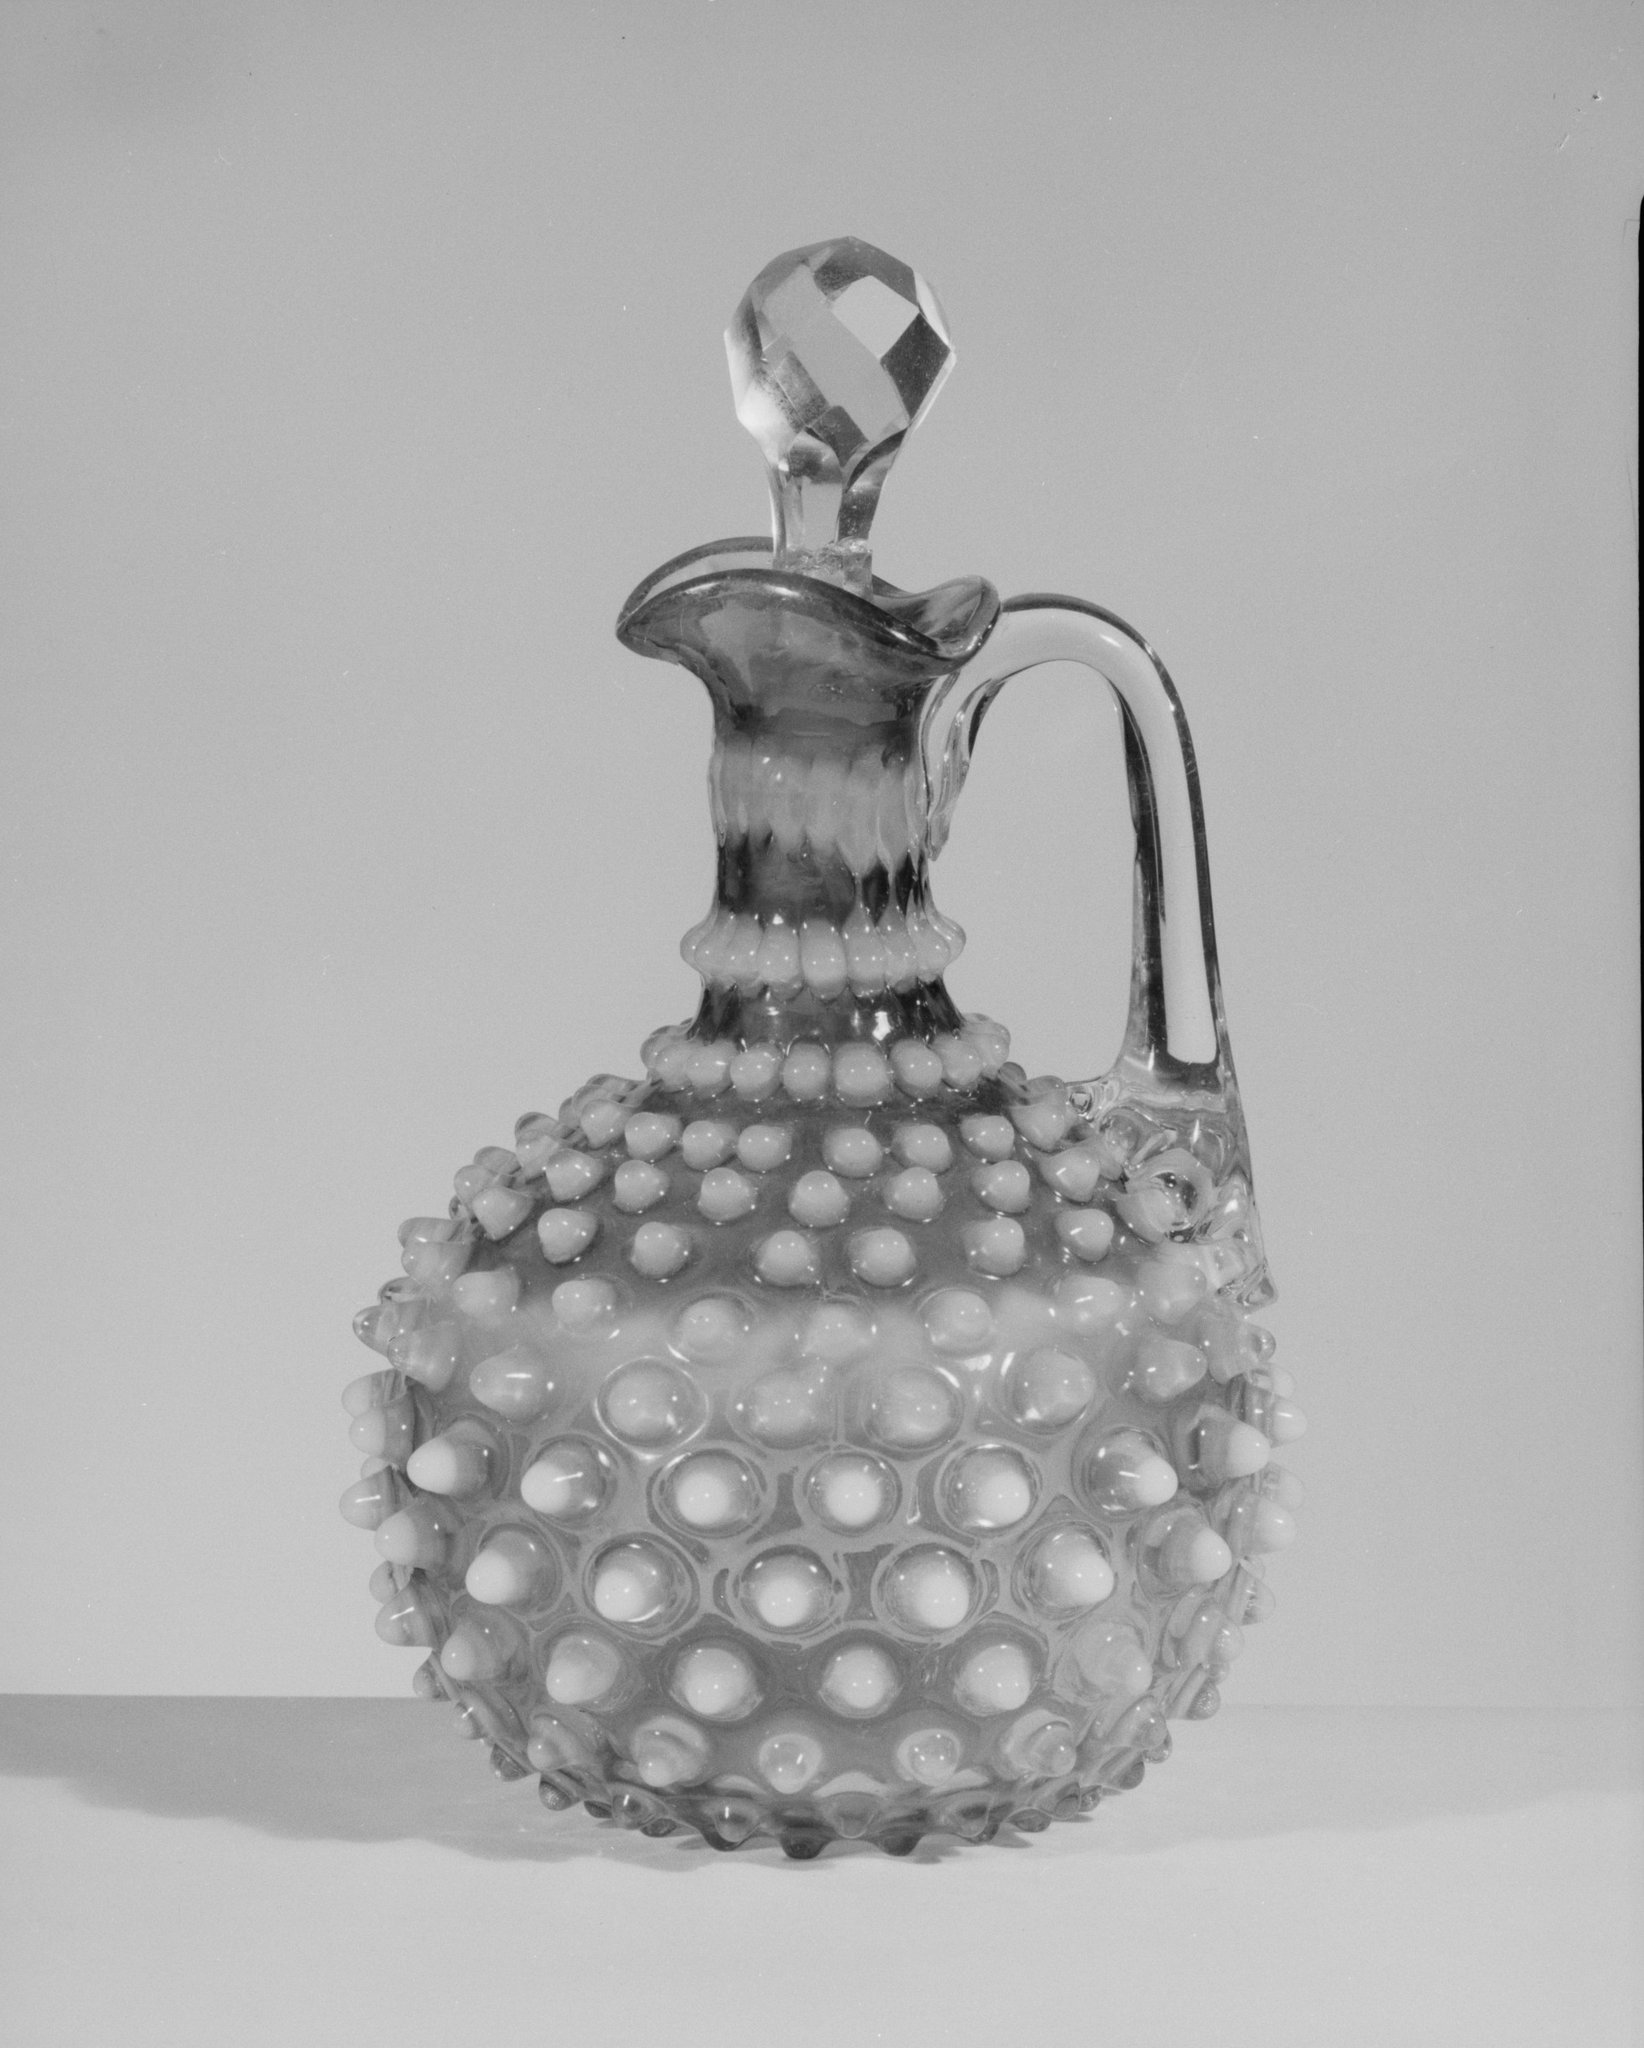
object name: cruet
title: Hobnail Cruet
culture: american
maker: hobbs, brockunier and company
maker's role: maker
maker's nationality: american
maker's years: 1863-1891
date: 1886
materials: glass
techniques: pressed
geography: united states